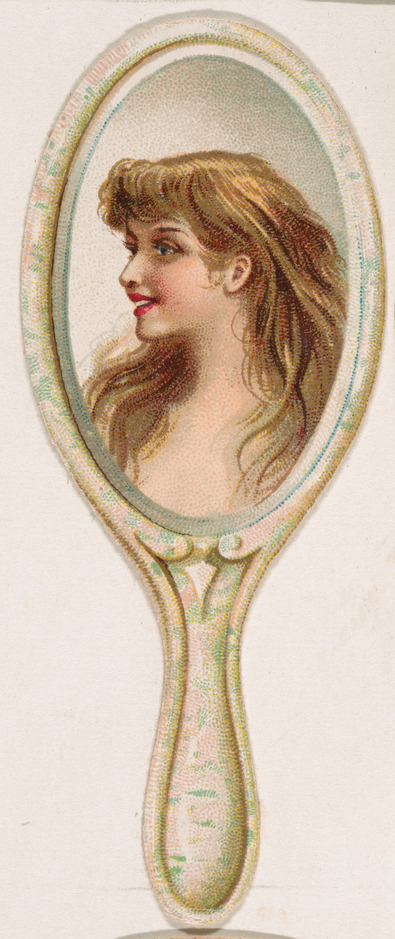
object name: print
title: Mirror, from the Novelties series (N228, Type 3) issued by Kinney Bros.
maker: kinney brothers tobacco company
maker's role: publisher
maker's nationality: american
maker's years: 1869-2011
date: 1889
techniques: color lithograph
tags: women,mirrors